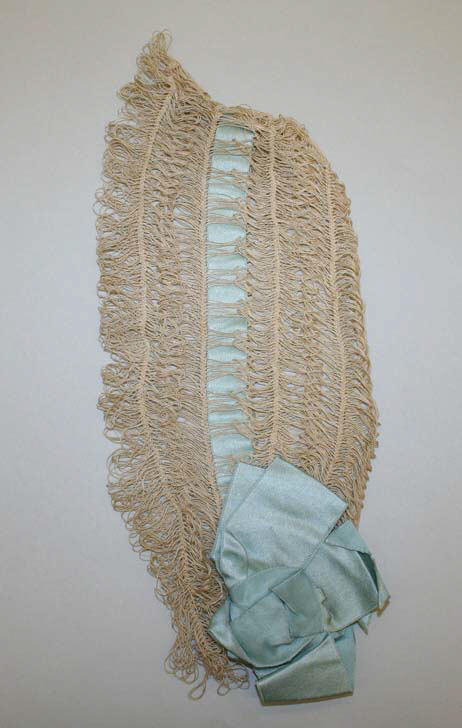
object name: cap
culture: american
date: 1880-1889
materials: cotton, silk